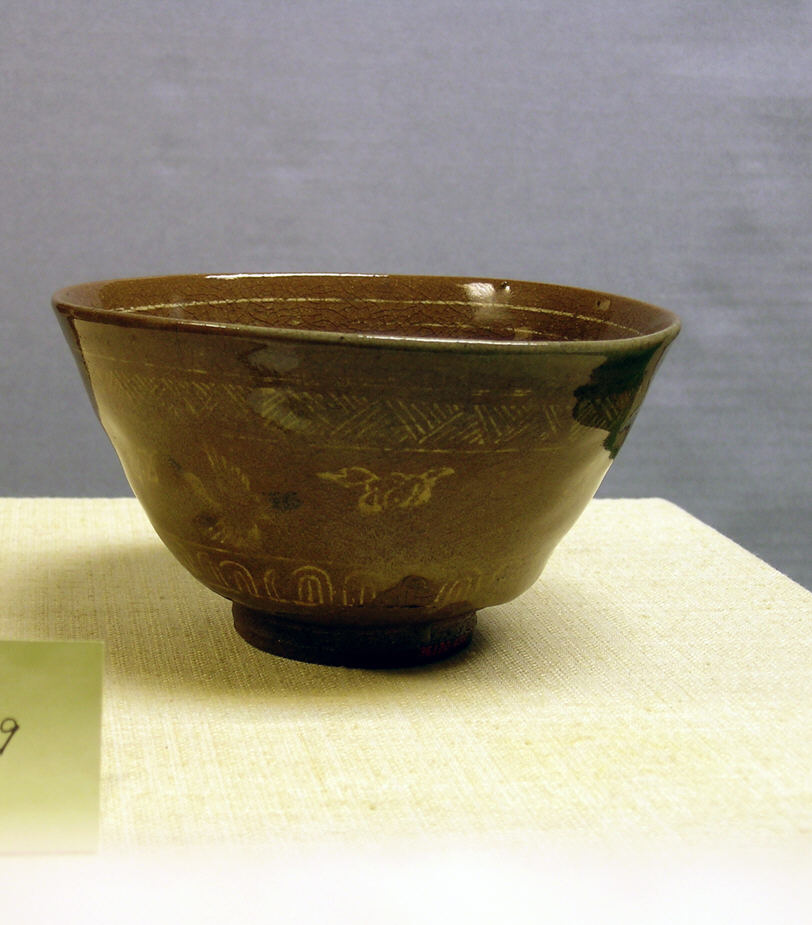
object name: teabowl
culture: japanese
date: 1780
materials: clay, glaze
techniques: inlay, underglaze